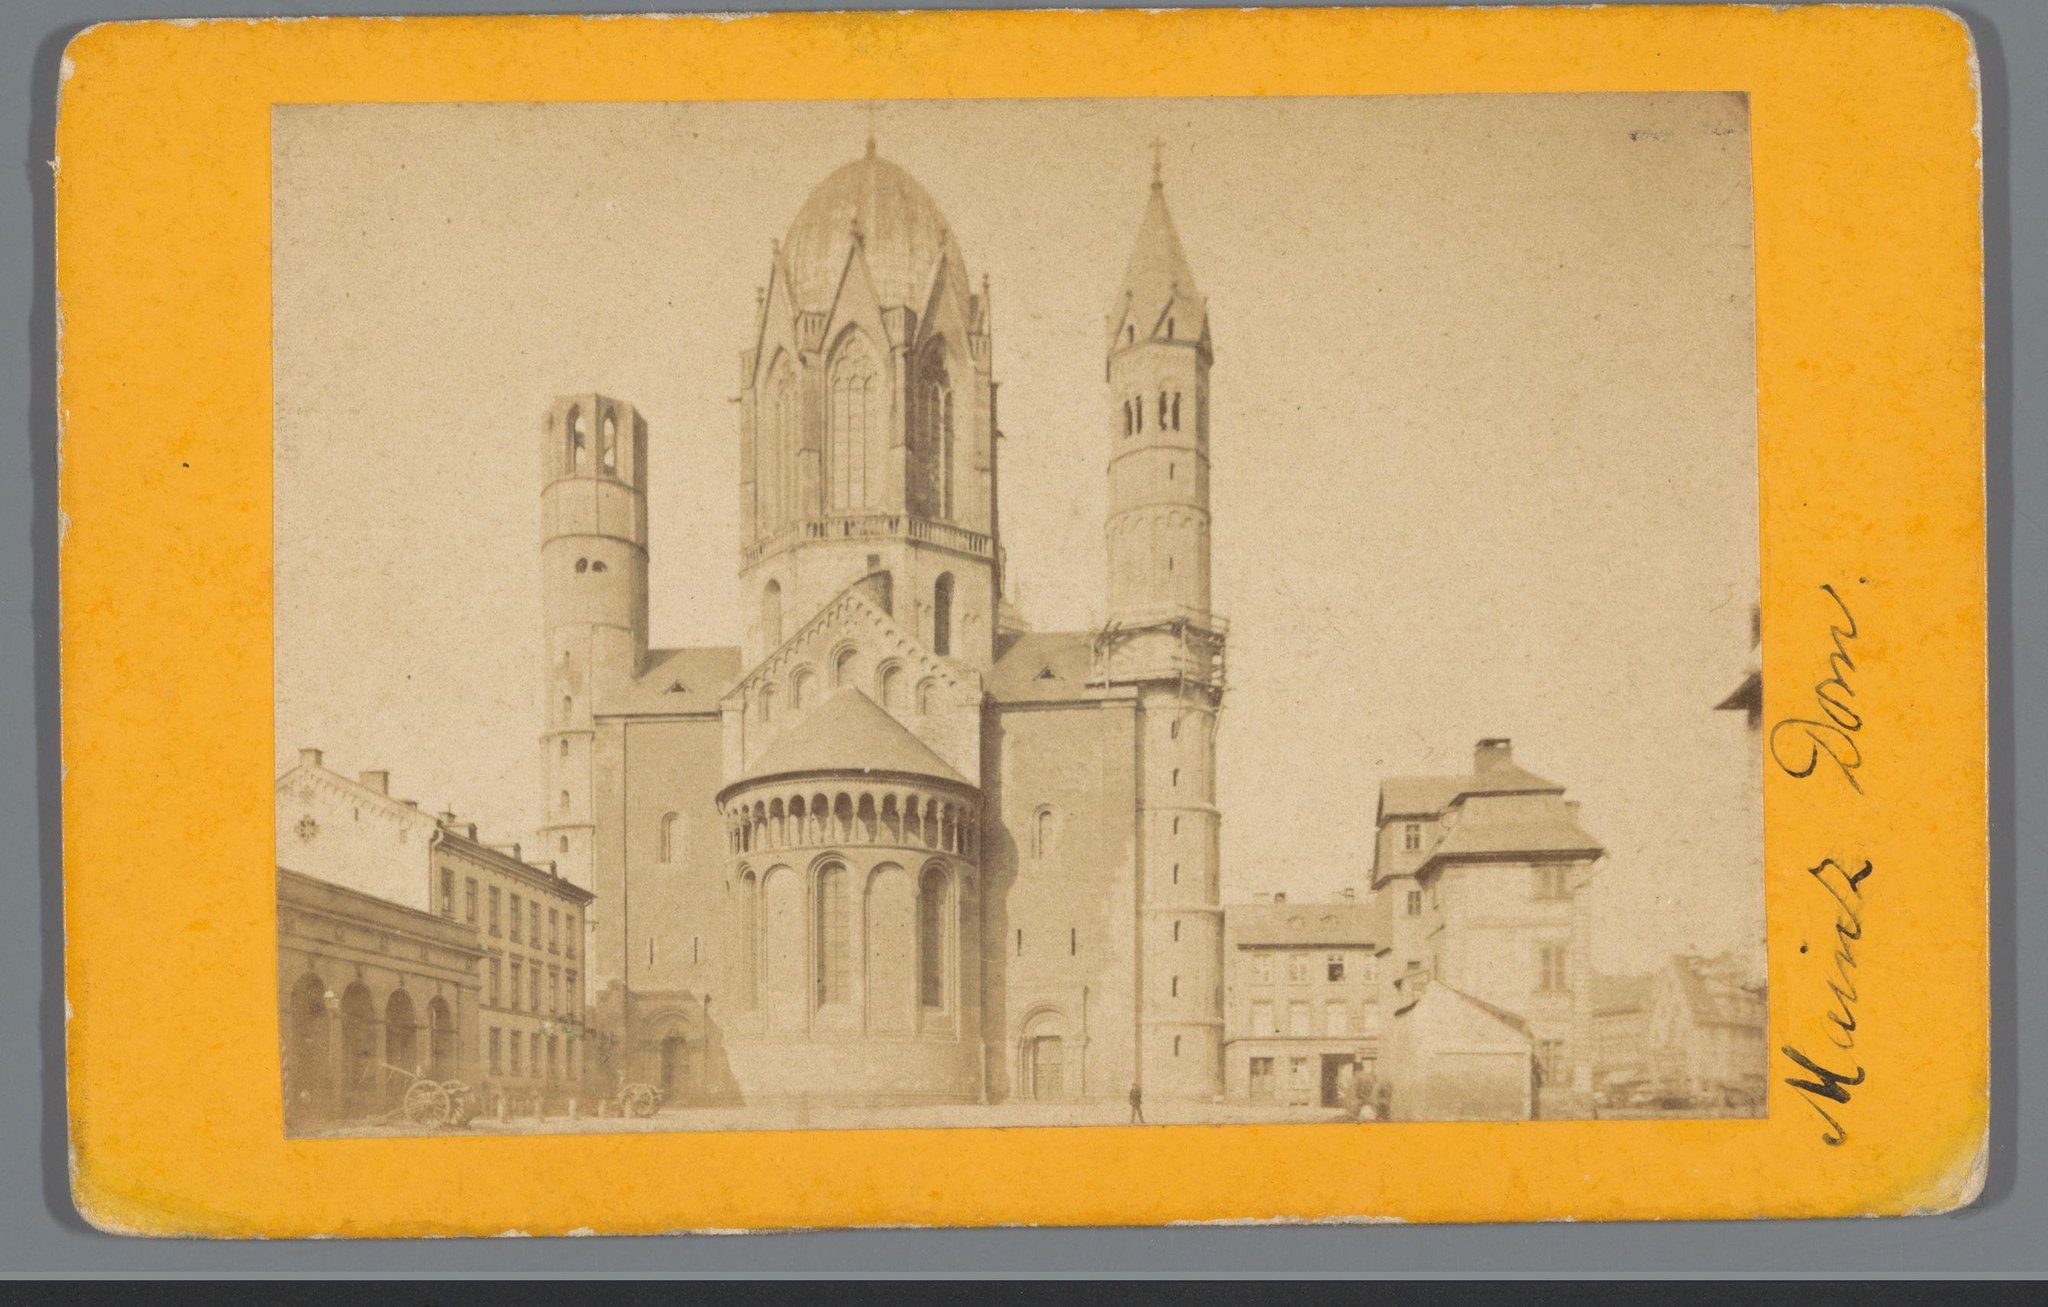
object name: photograph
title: Mainz Dom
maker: theodor creifelds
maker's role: publisher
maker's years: 1815-1875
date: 1855-1875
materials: cardboard, paper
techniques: albumen print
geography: mainz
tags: church (exterior)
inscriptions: inscription: ‘1081-1136’, inscription: ‘Photographische Anstalt/ von/ Th: Creifelds/ in/ CÖLN./ Domkloster.’, retailer's mark: ‘KUNSTHANDLUNG/ VON/ GESCHW. MICHIELS/ 31 PASSAGE/ CÖLN.’